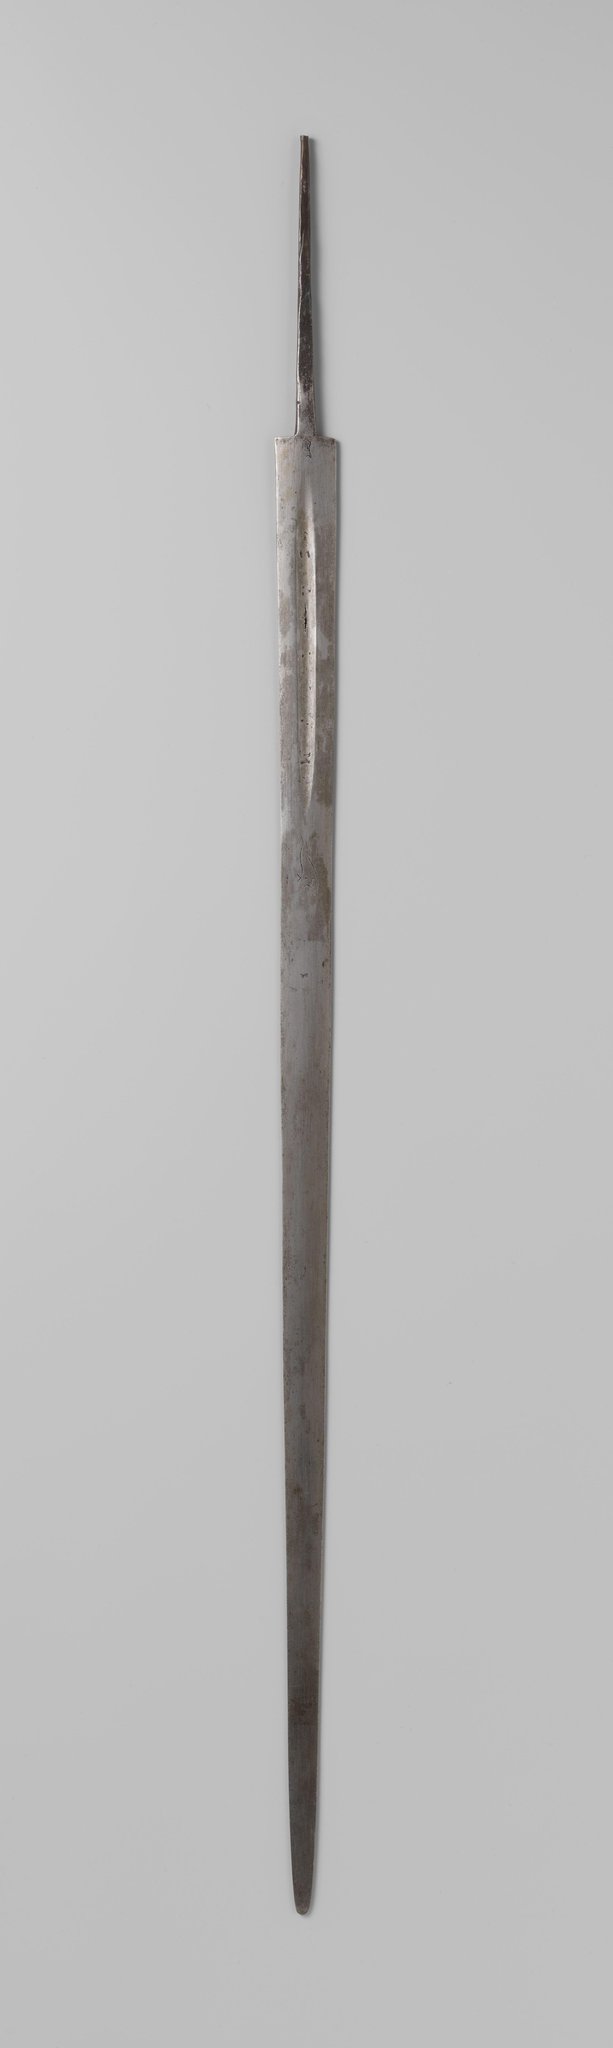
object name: knife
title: Kling voor ruiterdegen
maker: Anonymous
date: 1550-1900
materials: iron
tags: netherlands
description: Sabelkling zonder gevest, gemerkt 'SAHAGOM' en voorzien van lopend dier.